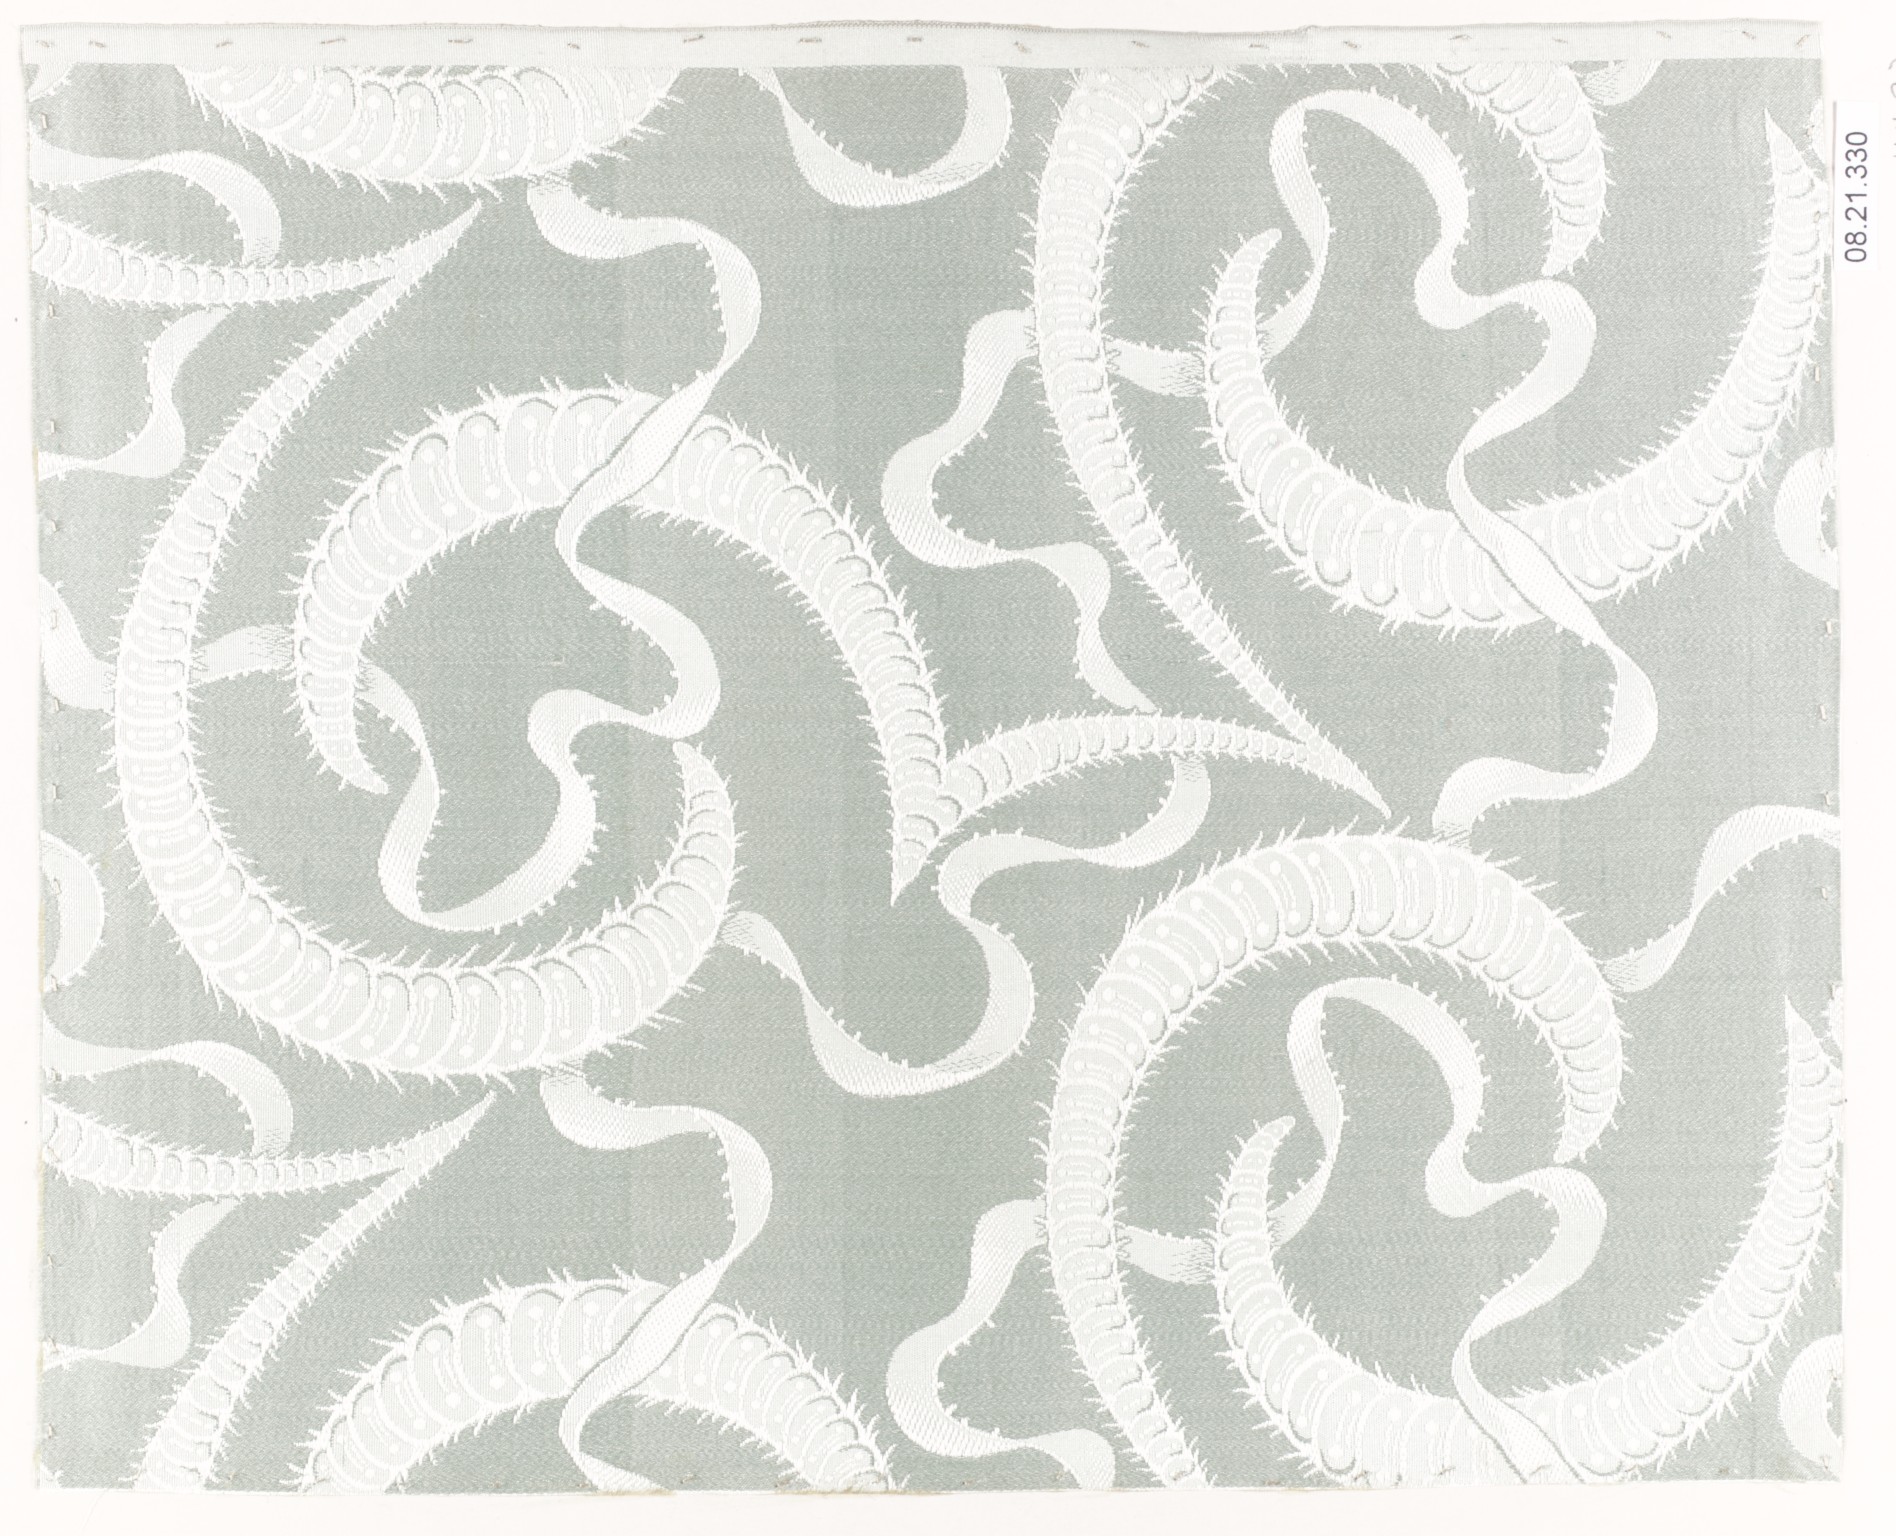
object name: textile sample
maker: Anonymous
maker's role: designer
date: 1900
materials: silk